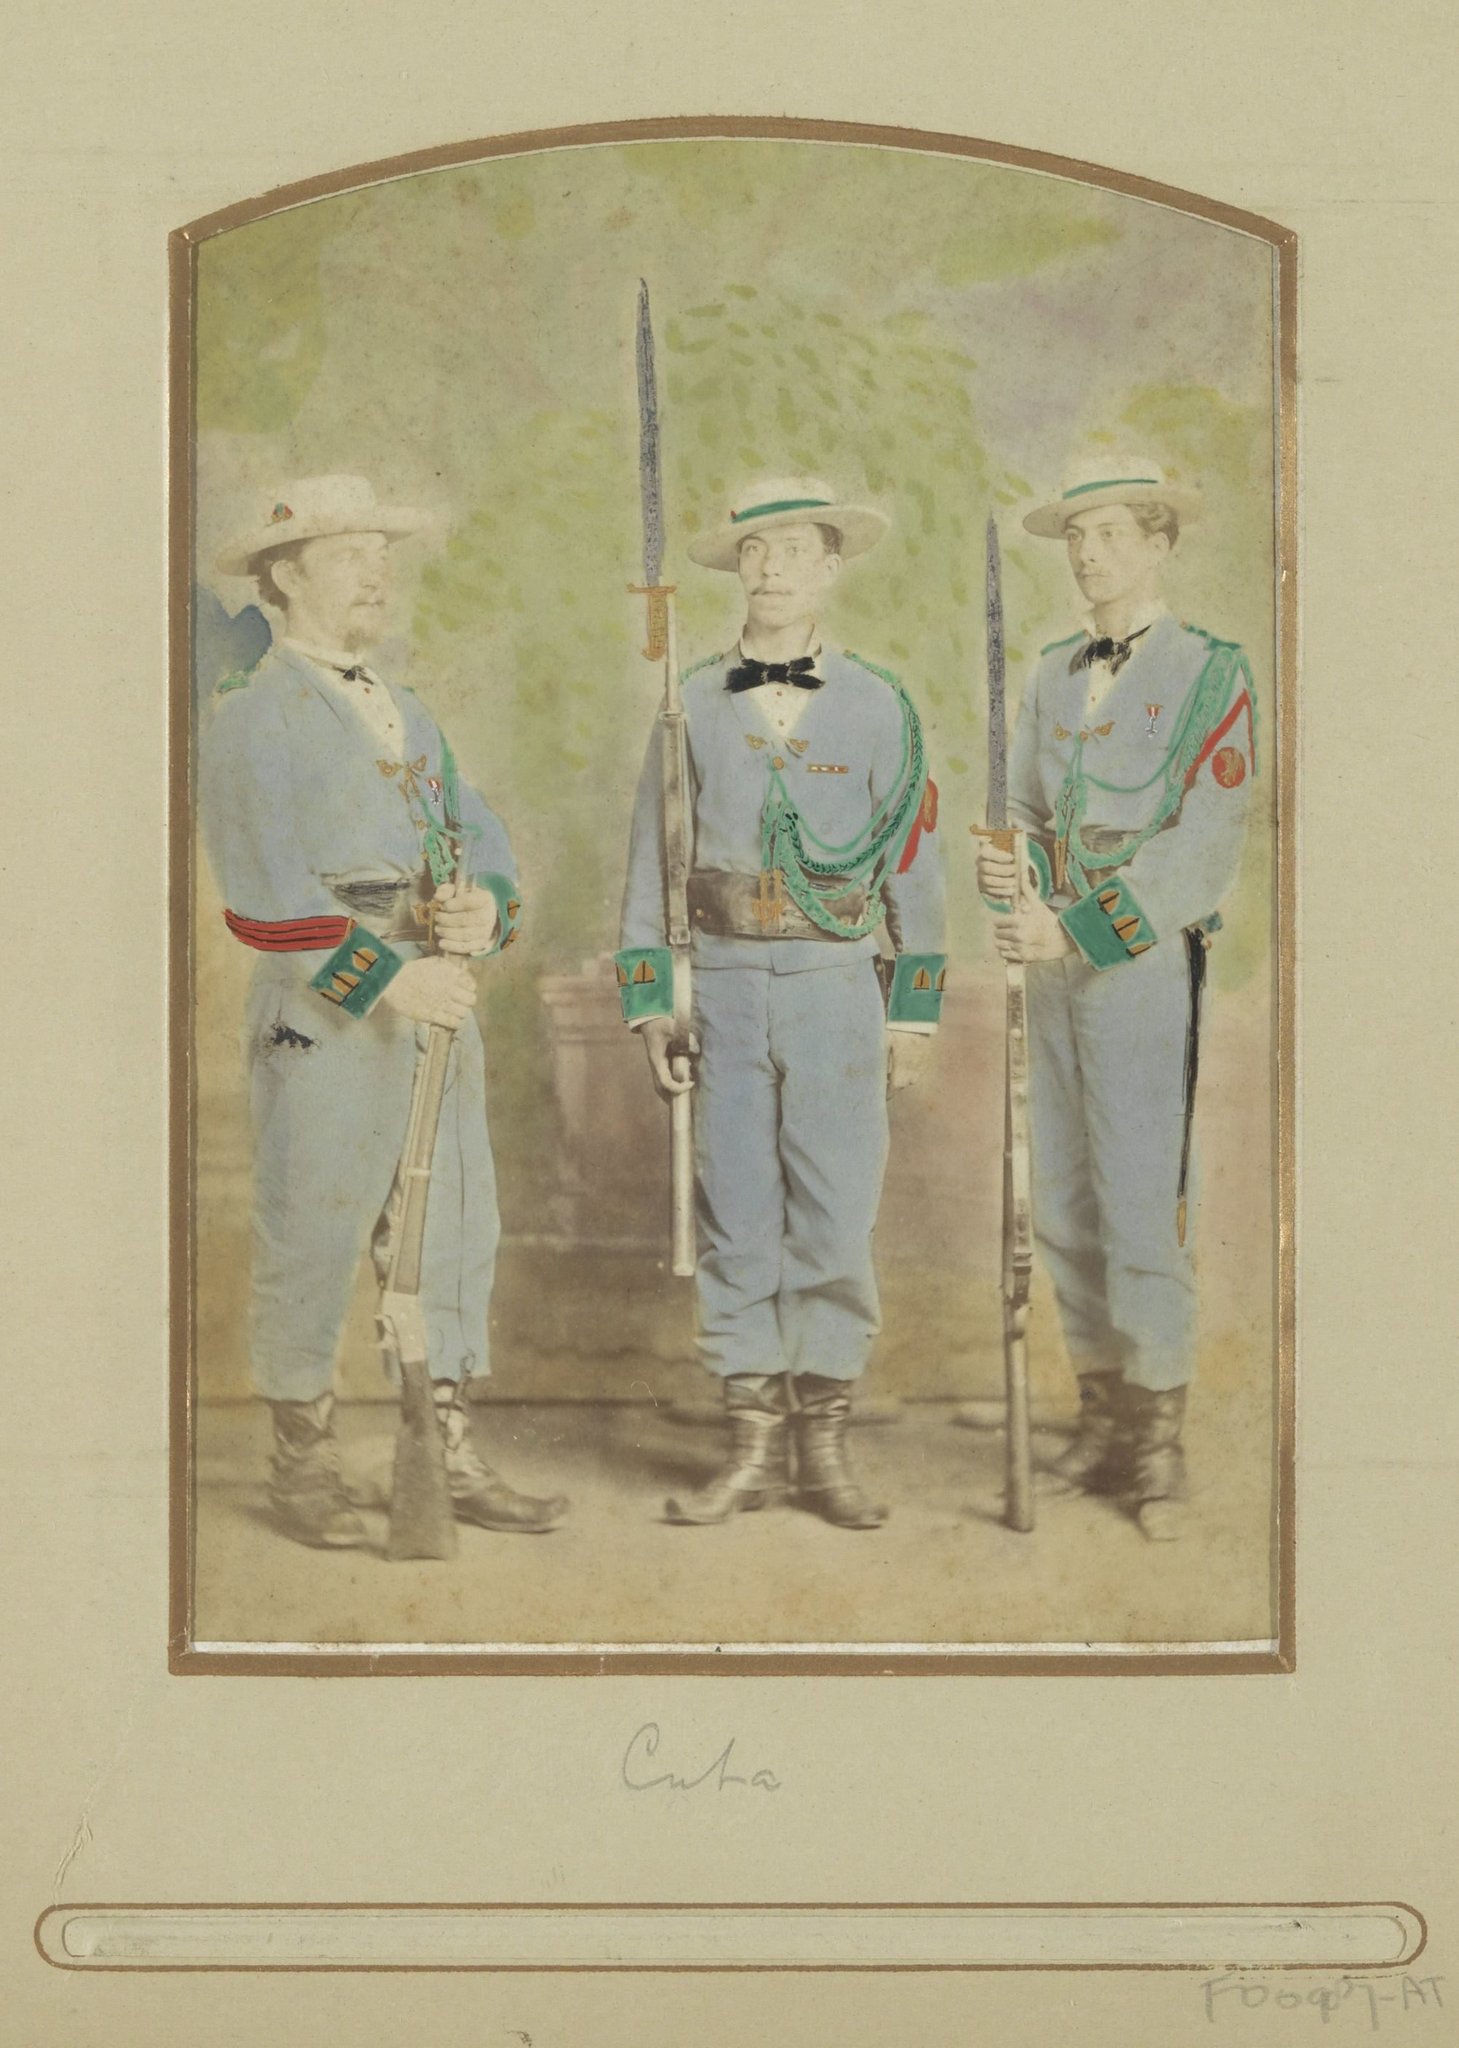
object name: cabinet photograph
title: Batallon 2º de Ligeros. Stana Mayor. Paladores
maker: a.a. cohner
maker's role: fotograaf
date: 1870-1900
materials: cardboard, paper, photographic support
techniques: albumen print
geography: cuba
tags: firearms: rifle, warfare; military affairs, (military) uniforms, division of armed forces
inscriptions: address: ‘Calle de O'Reilly, 62, Habana / Rue de Rivoli, 79, Paris.’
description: Onderdeel van Album met cartes-de-visite en kabinetfoto's van militairen in uniform.